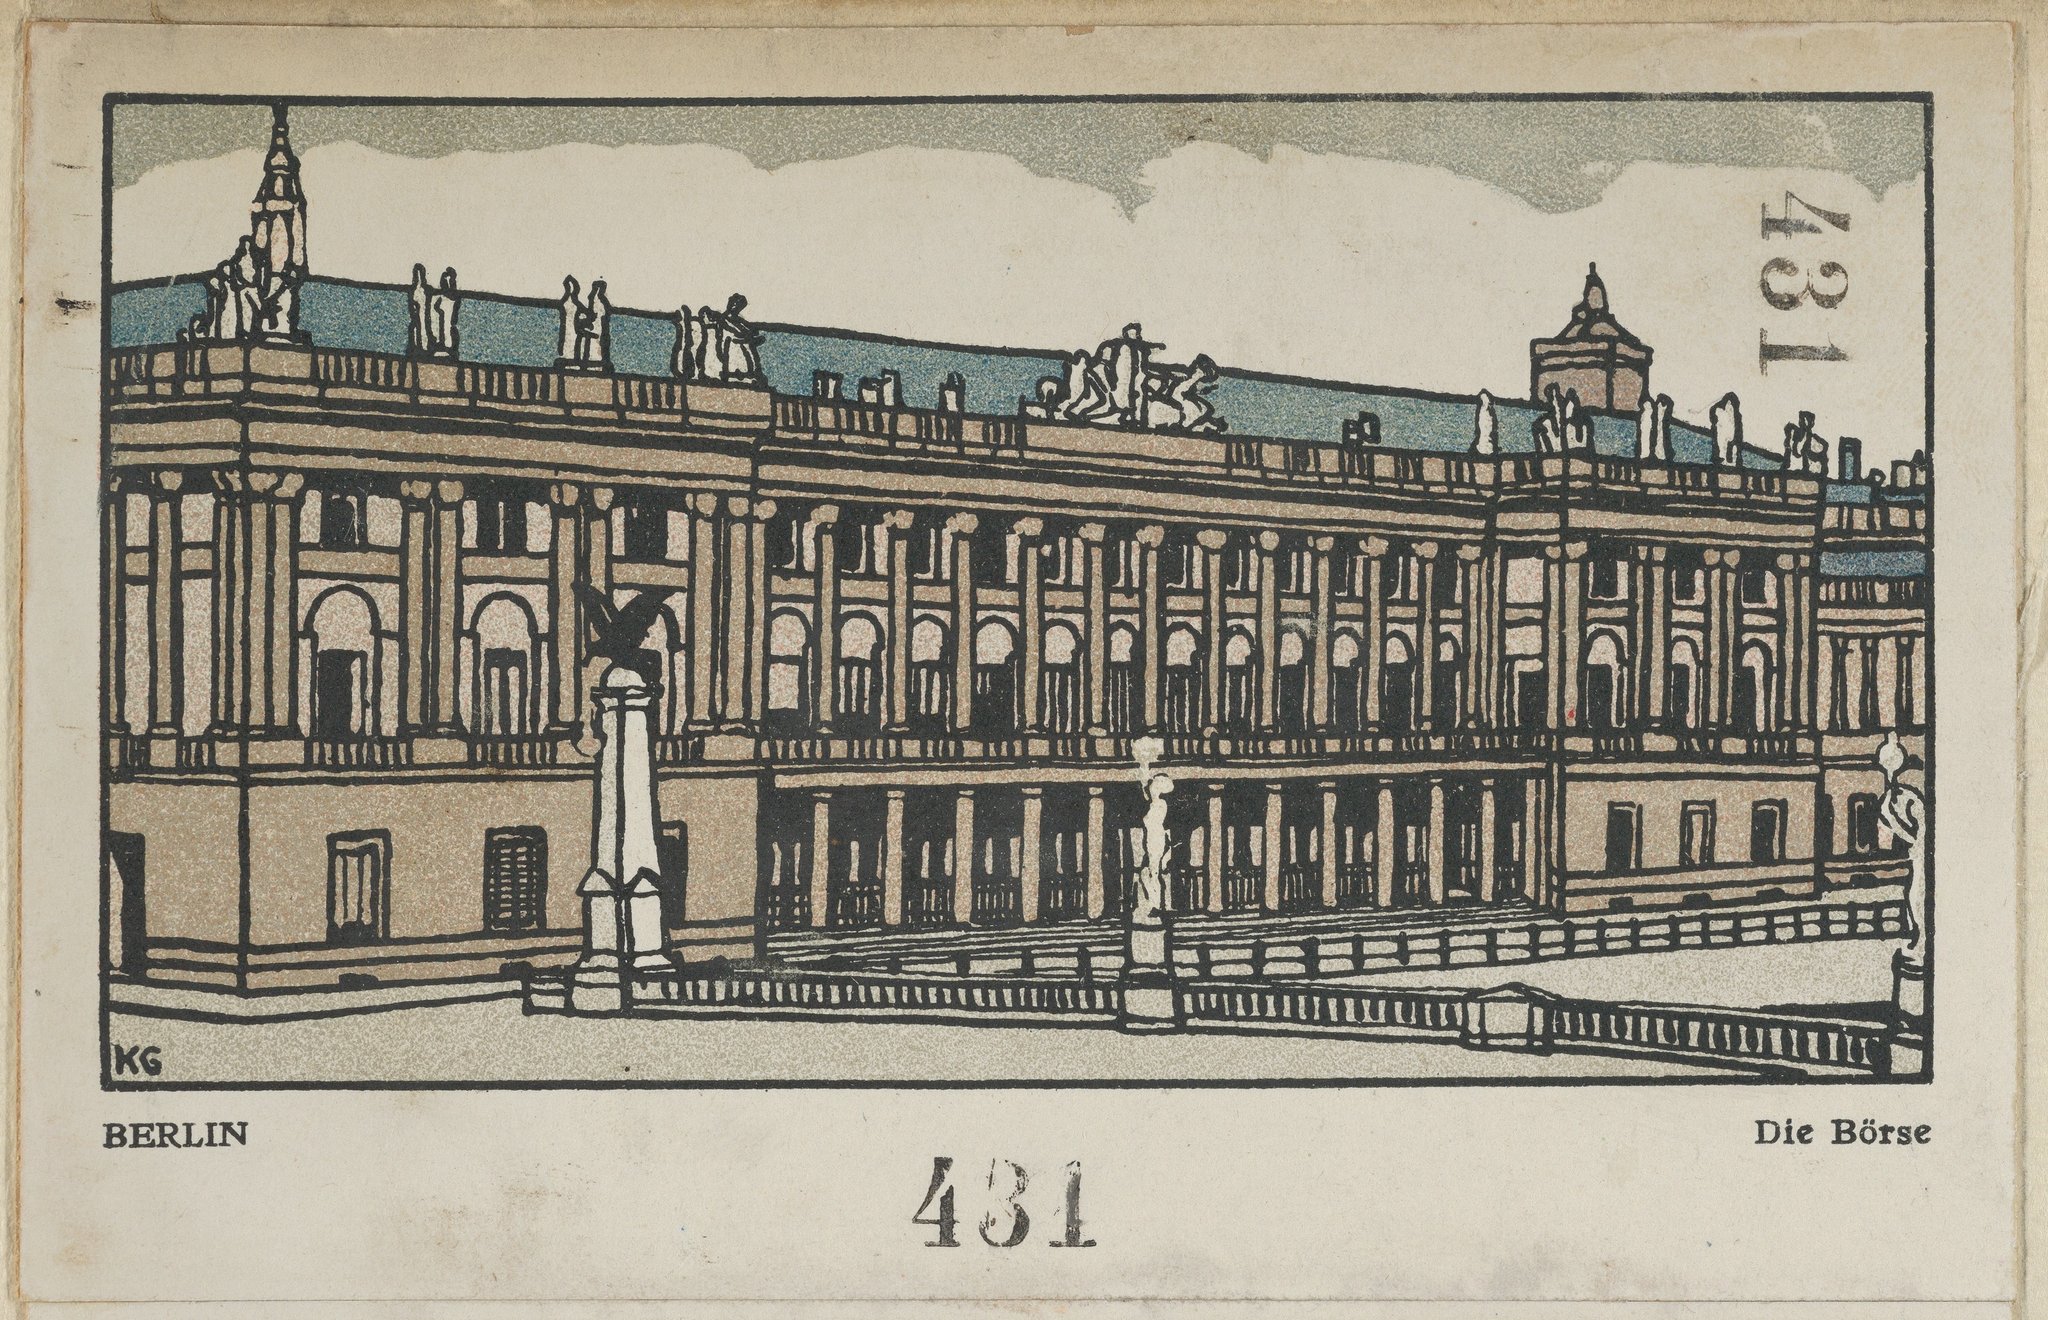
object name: print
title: Berlin: Stock Exchange (Die Börse)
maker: gustav kalhammer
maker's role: artist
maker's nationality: austrian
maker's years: 1886-1919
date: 1911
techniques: lithograph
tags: buildings